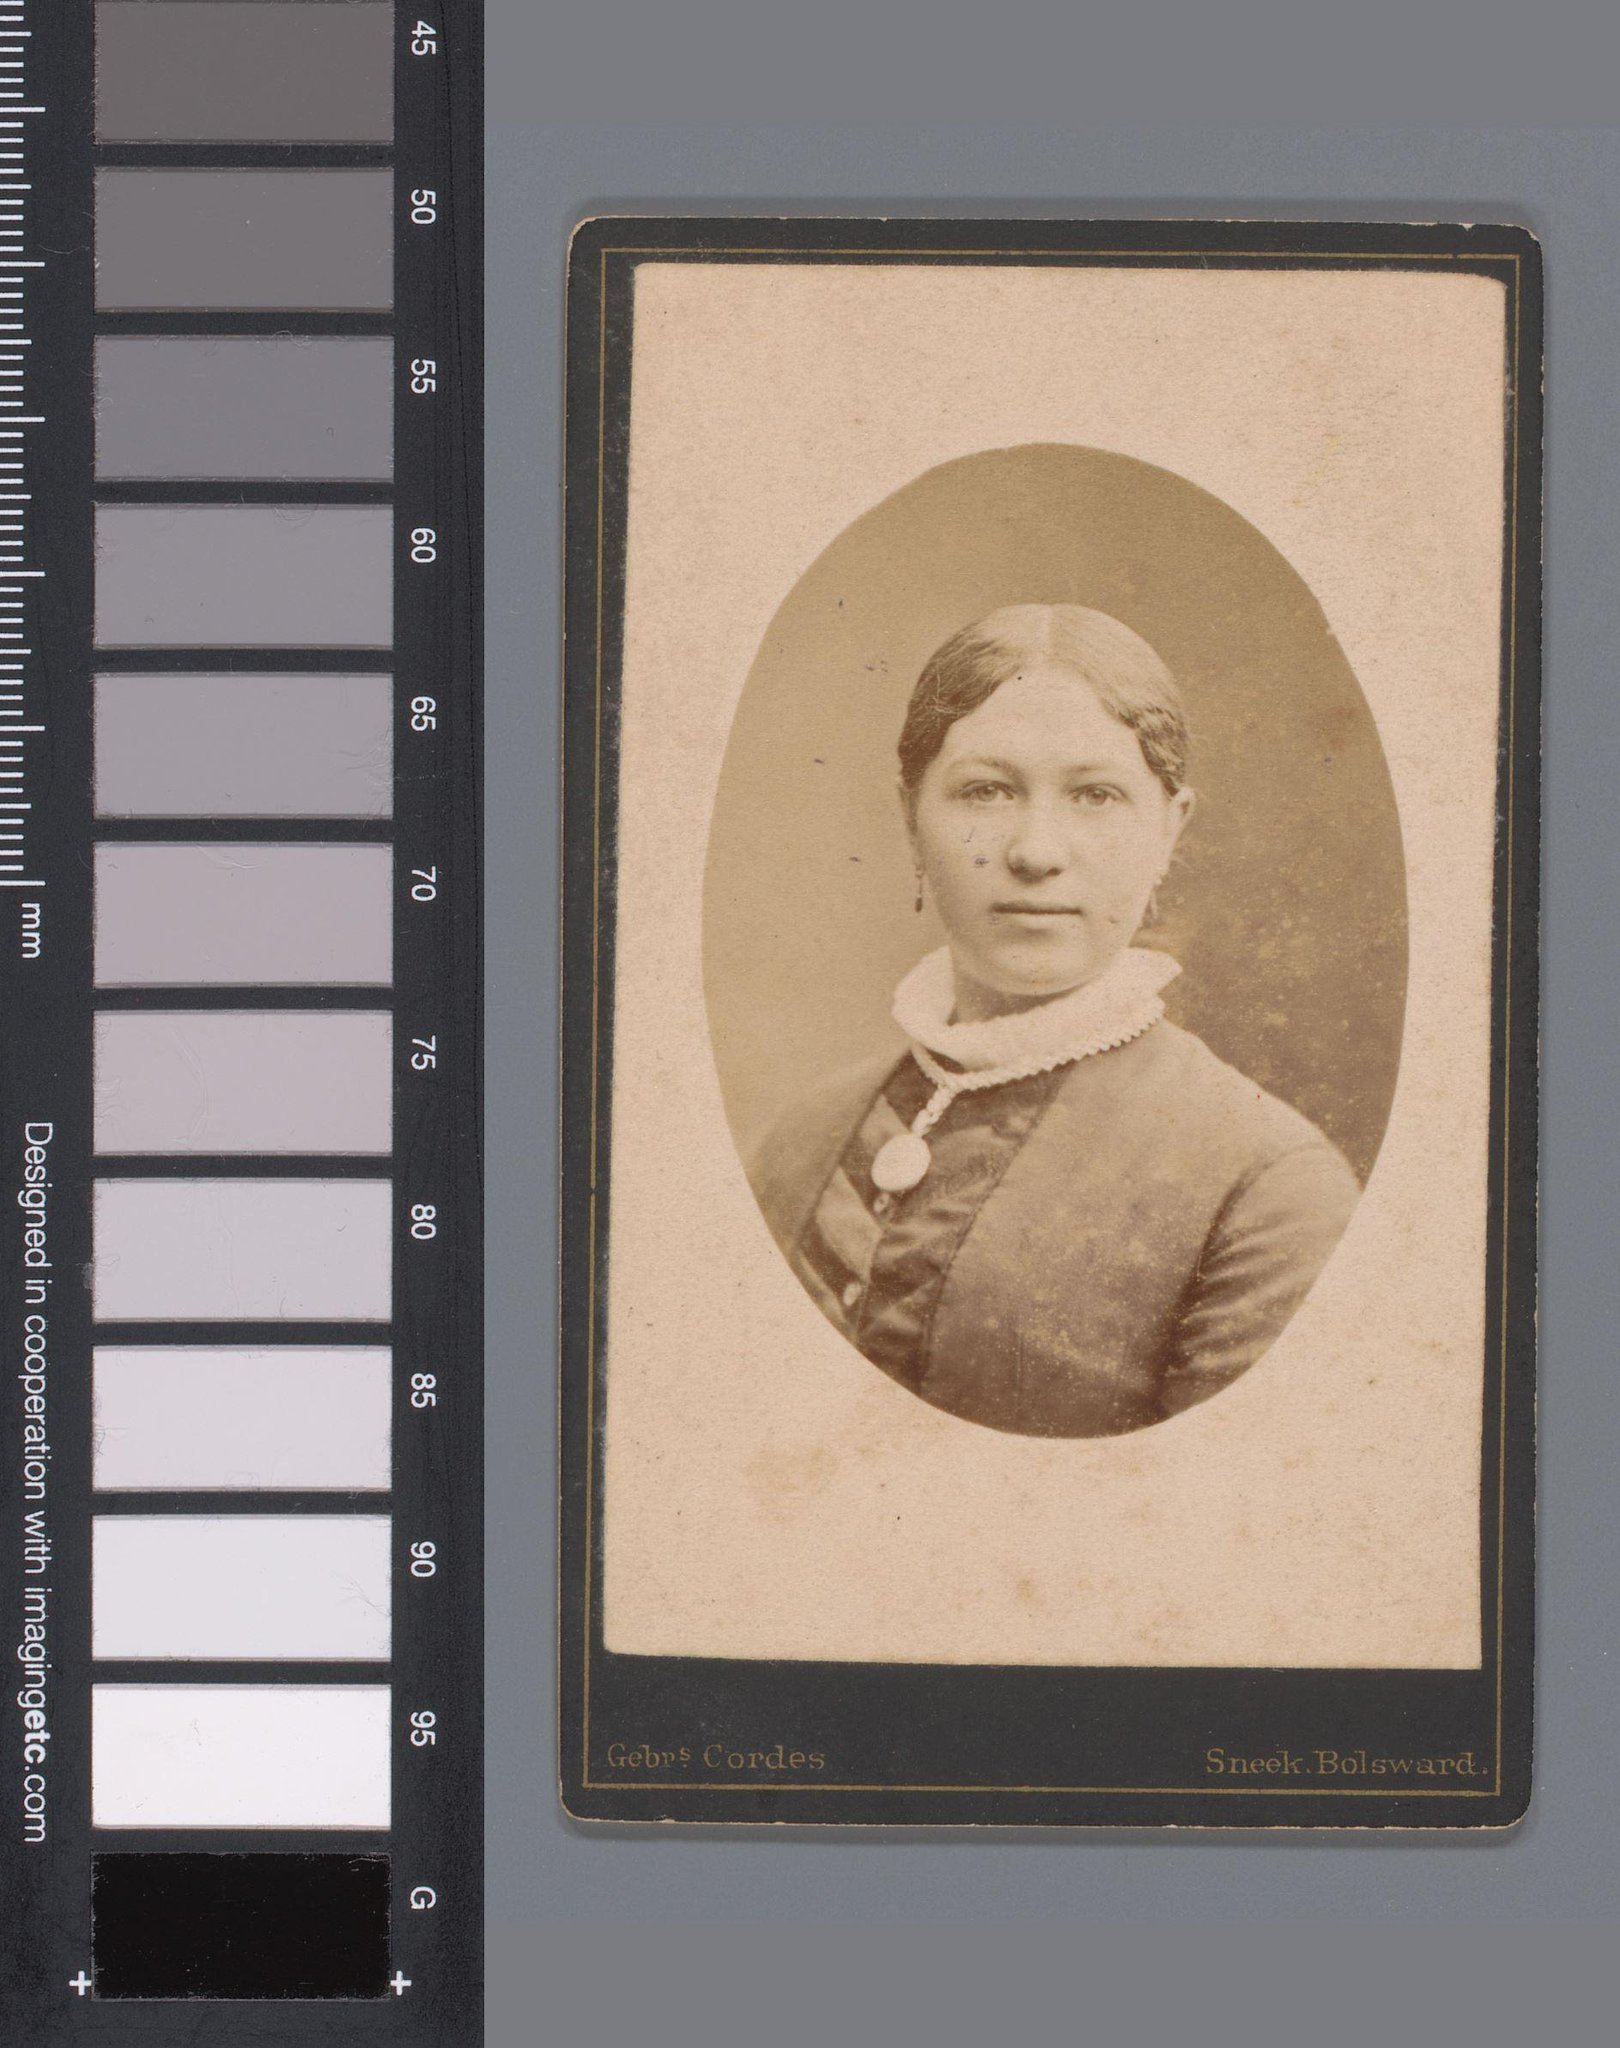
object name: carte de visite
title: Portret van een onbekende vrouw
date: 1881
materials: cardboard, paper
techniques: albumen print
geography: sneek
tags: adult woman, anonymous historical person portrayed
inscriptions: inscription: ‘Byzondere inrichtingen voor vergrootingen à charbon./ Van alle portretten kunnen steeds nabesteld worden.’